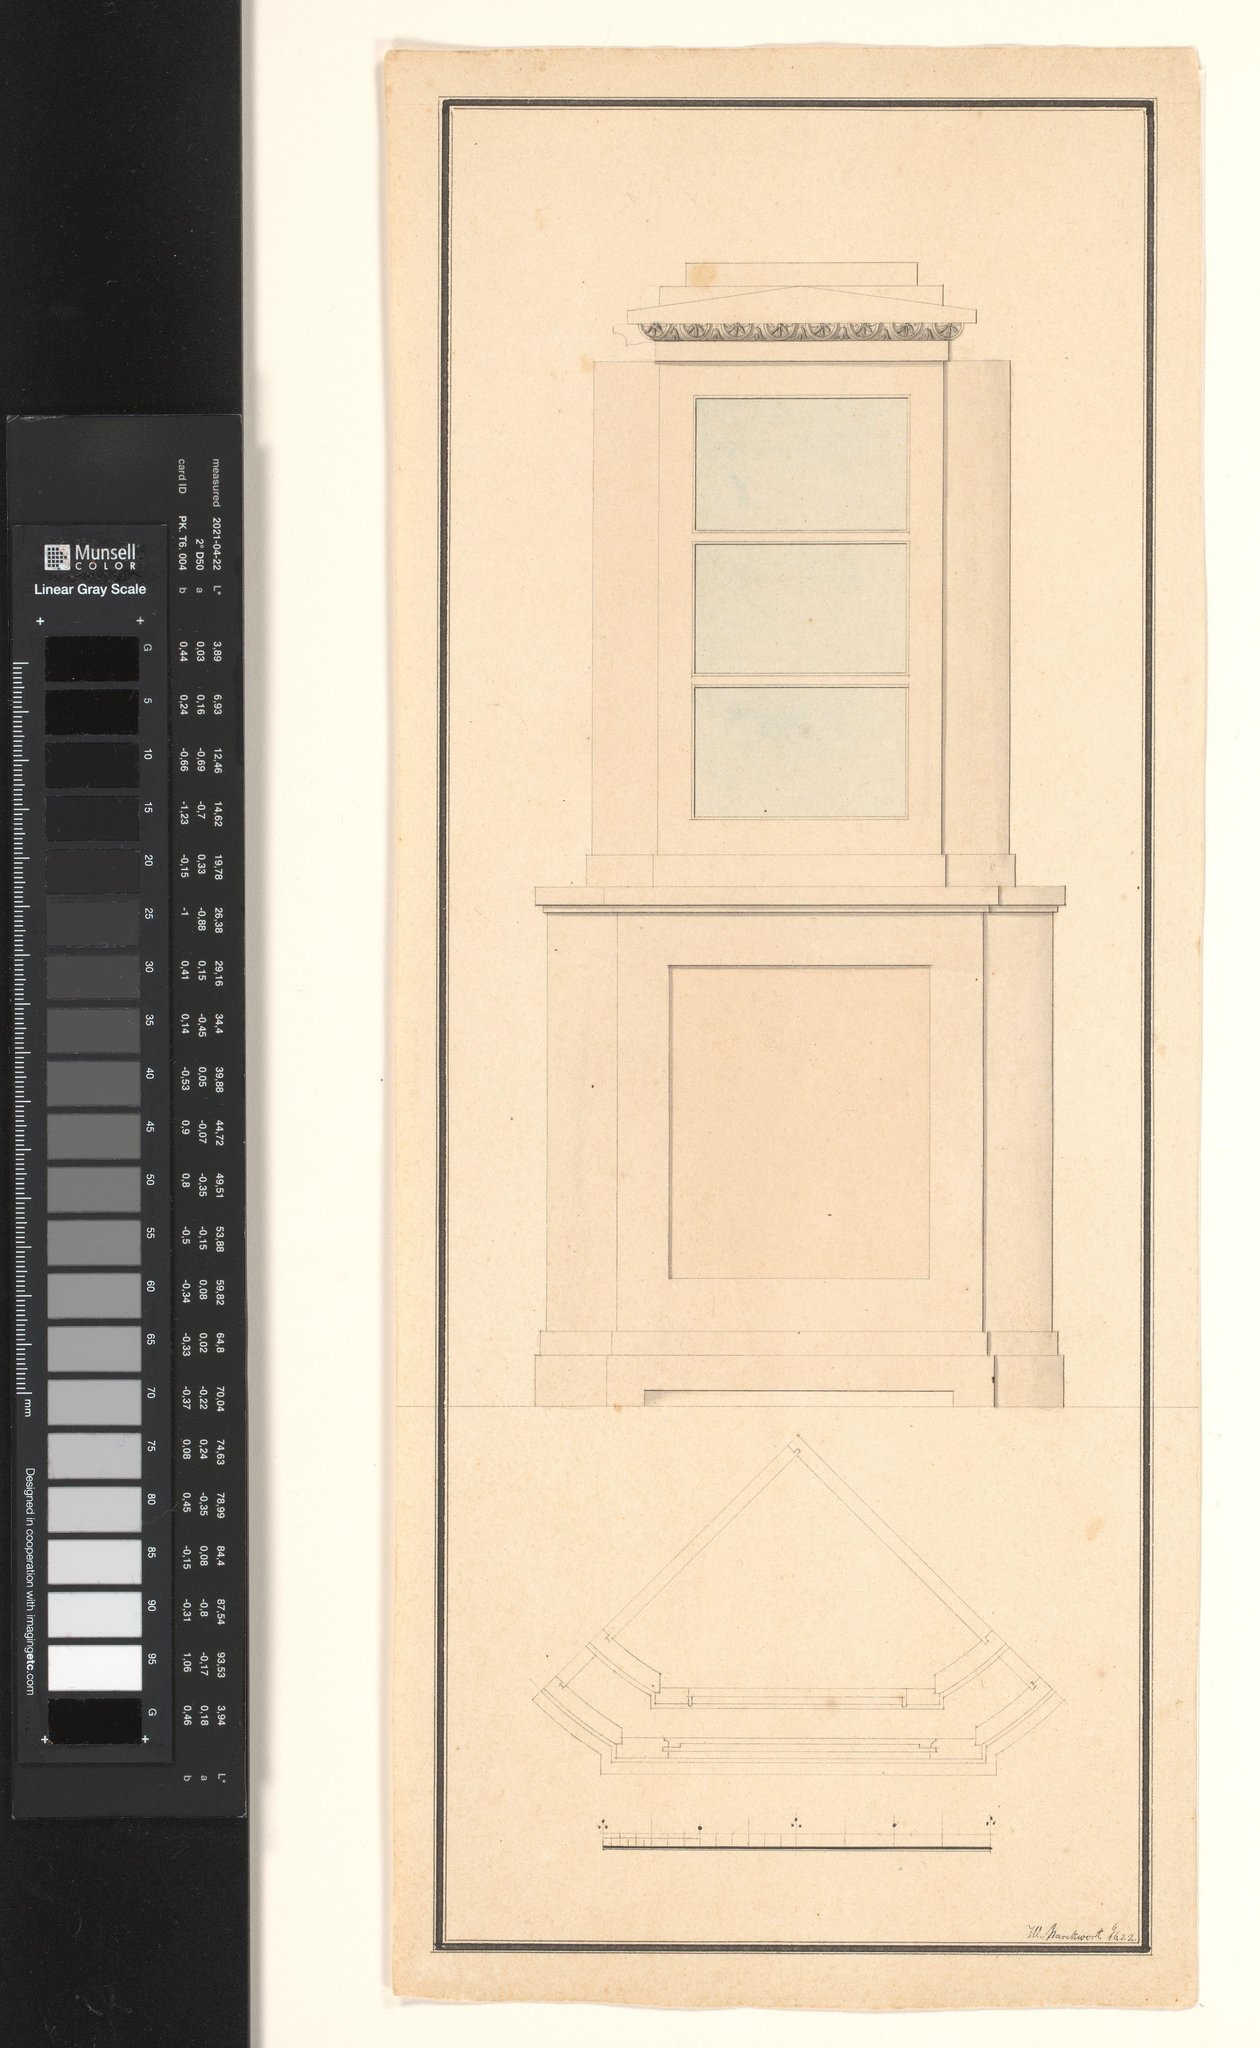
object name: design drawing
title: Ontwerp voor een hoekkast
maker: carl wilhelm marckwort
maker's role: draughtsman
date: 1822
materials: ink, paper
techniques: brush, pen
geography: berlin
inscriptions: signature and date: ‘W. Marckwort. 6/16. 22.’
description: Hoekkast met drie ruiten in de bovenkast, vooraanzicht met daaronder plattegrond en maatverdeling.